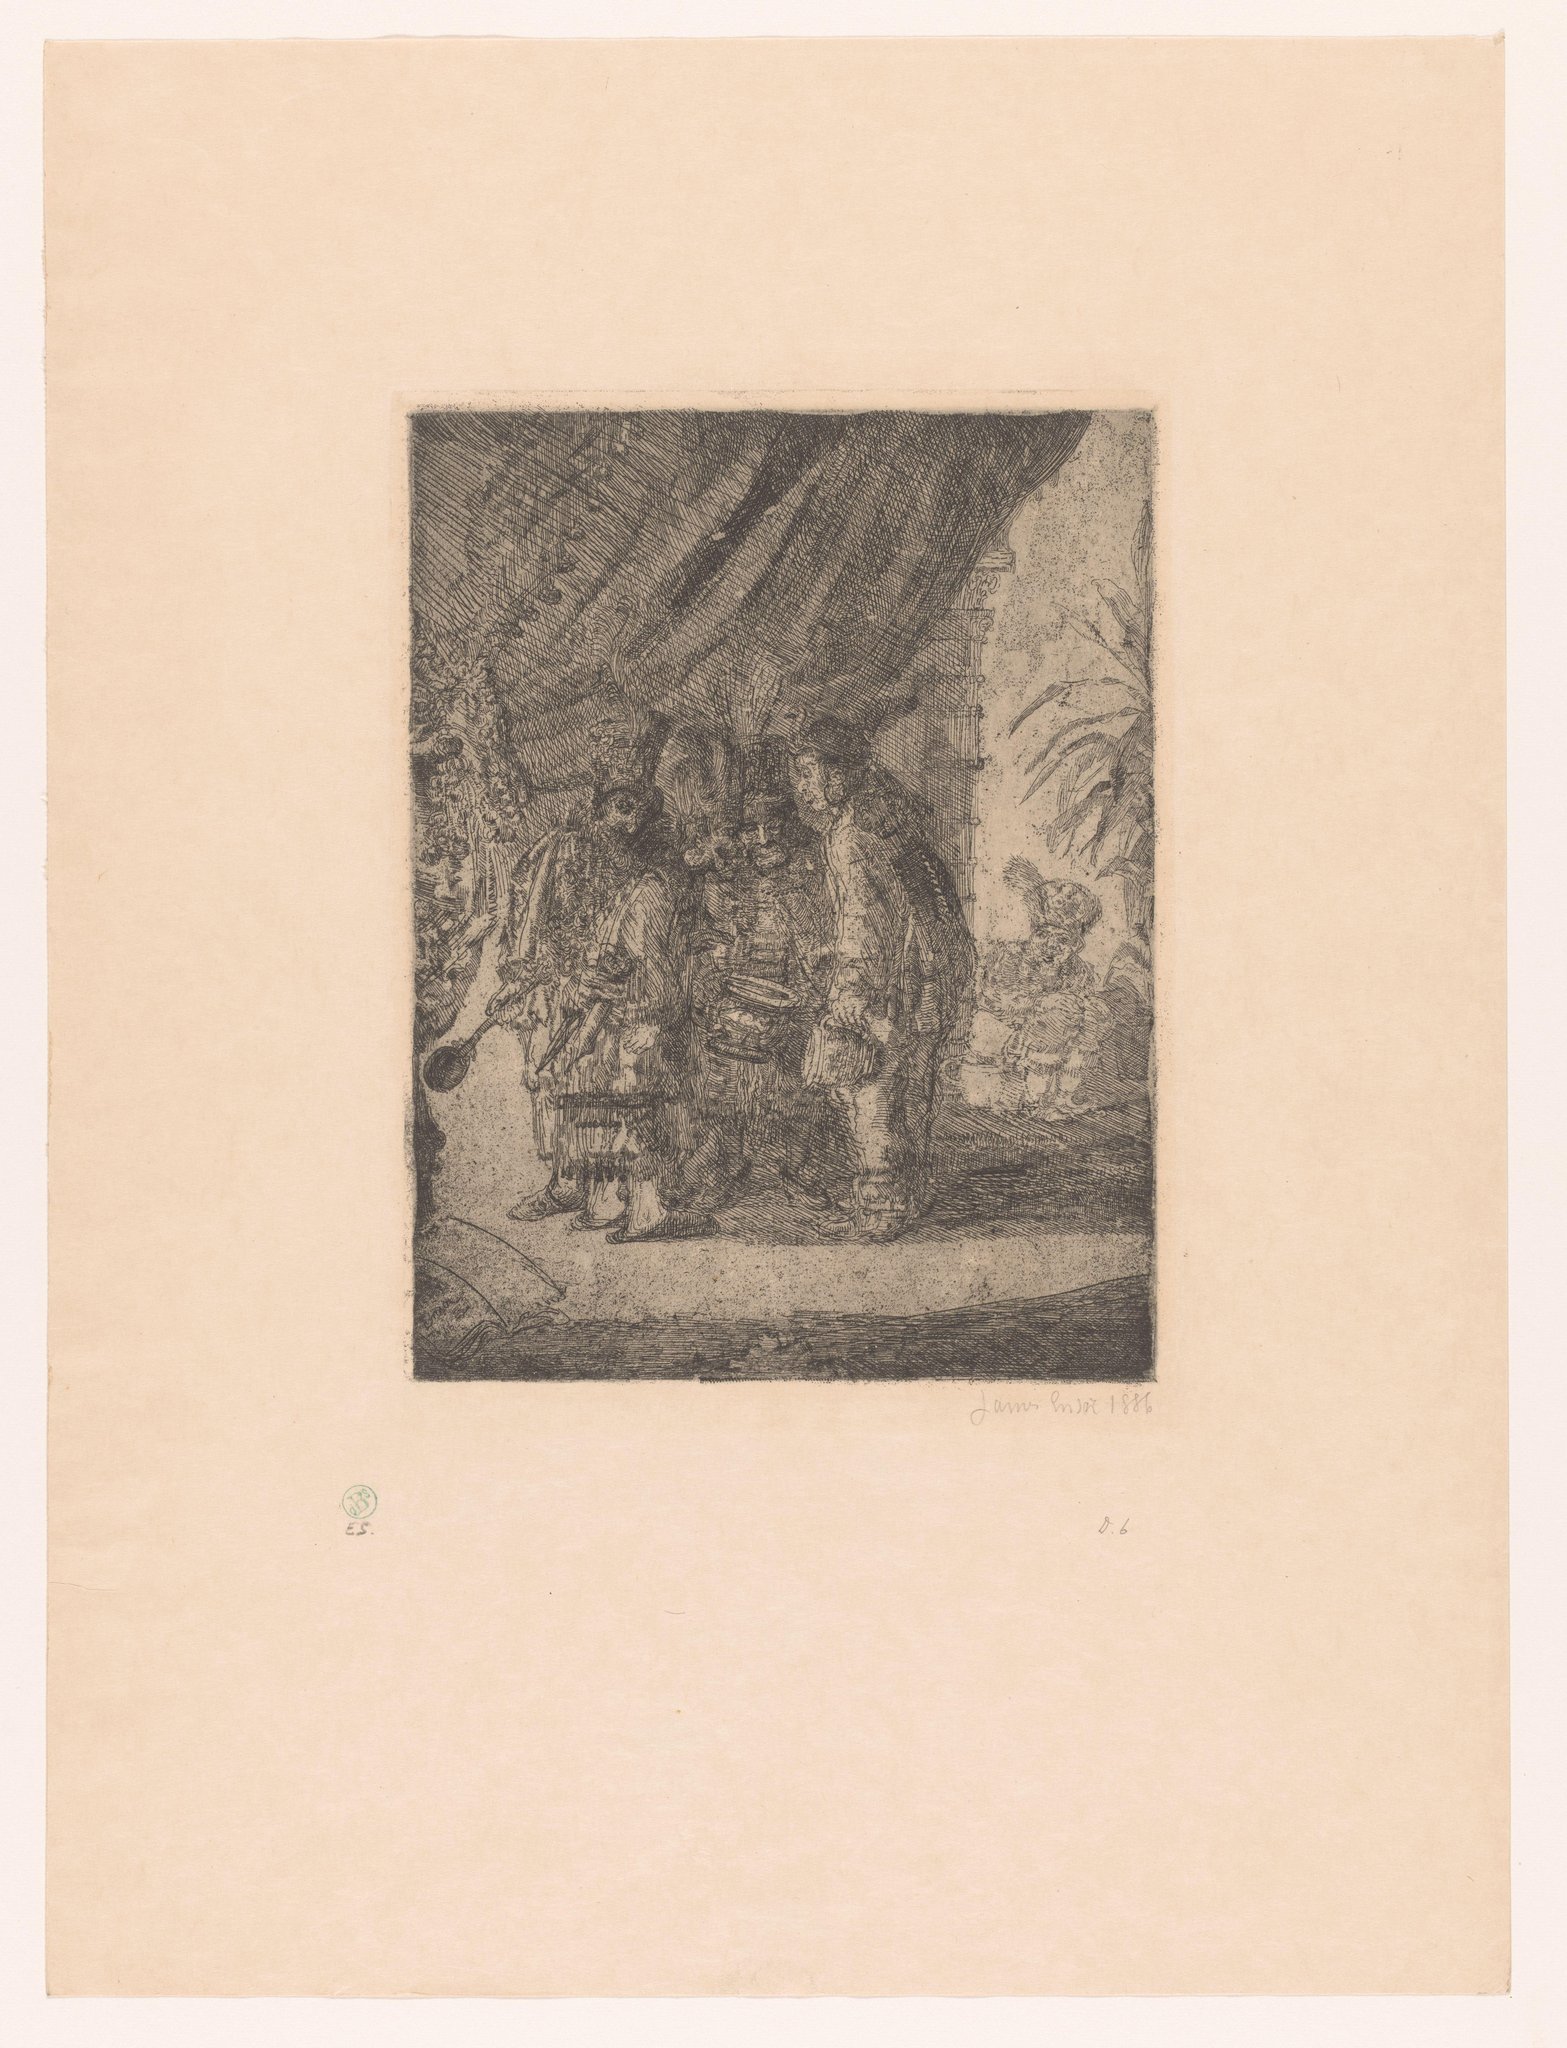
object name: print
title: Iston, Pouffamatus, Cracozie et Transmouff, célèbres médecins persans examinant les selles du roi Darius après la bataille d'Arbelles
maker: james ensor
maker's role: print maker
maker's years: 1860-1949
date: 1886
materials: paper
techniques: etching, intaglio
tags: physician, doctor, defecation, (story of) darius, king of persia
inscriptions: collector's mark: Lugt 733, collector's mark: Lugt 2760, collector's mark: Lugt 2228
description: Iston, Pouffamatus, Cracozie en Transmouffe, Perzische geneesheren, onderzoeken de stoelgang van Darius na de slag van Arabela.